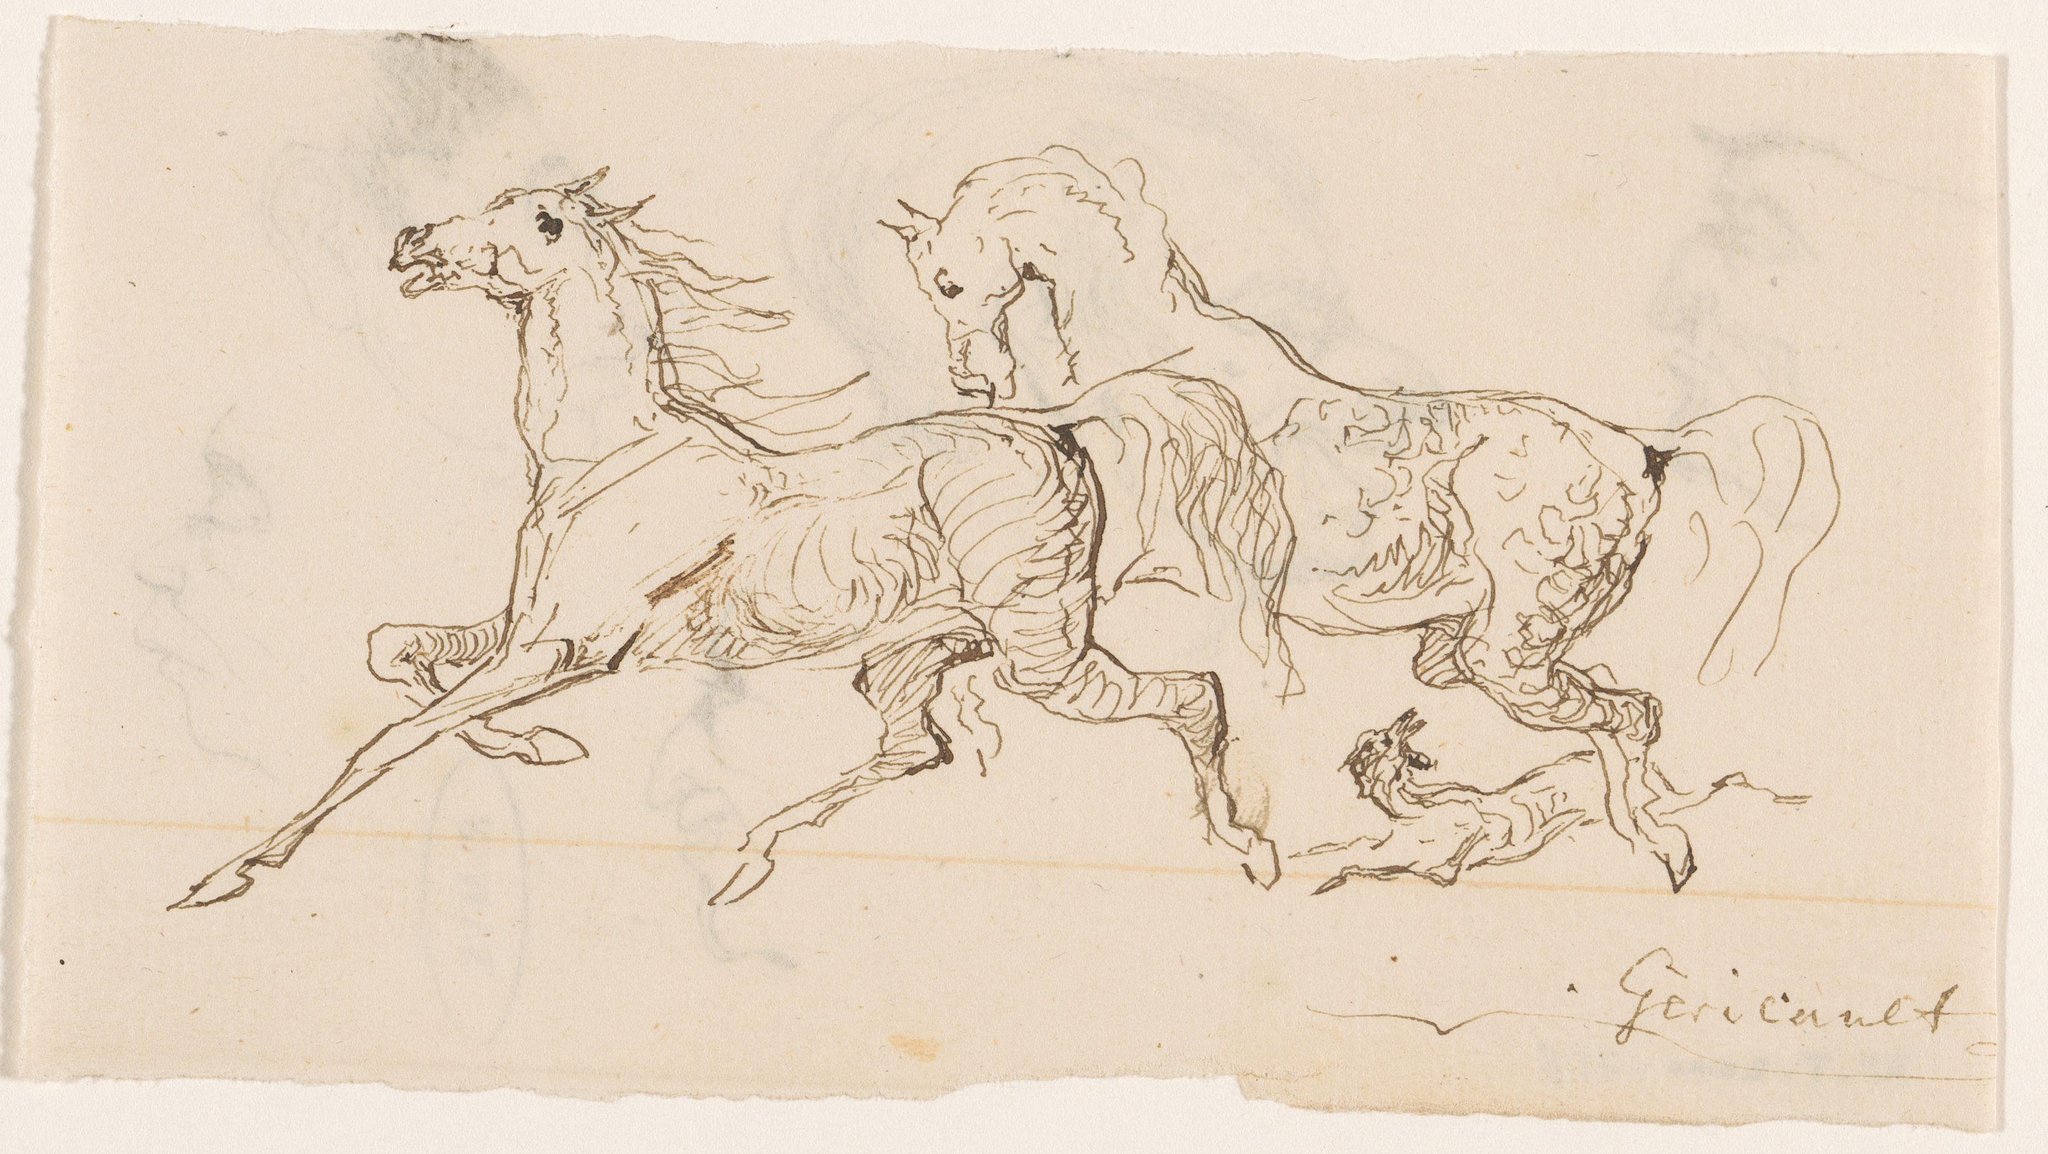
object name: drawing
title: Twee paarden en een hond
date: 1840-1880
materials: ink, paper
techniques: pen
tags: horse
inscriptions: annotation: ‘Gericault’